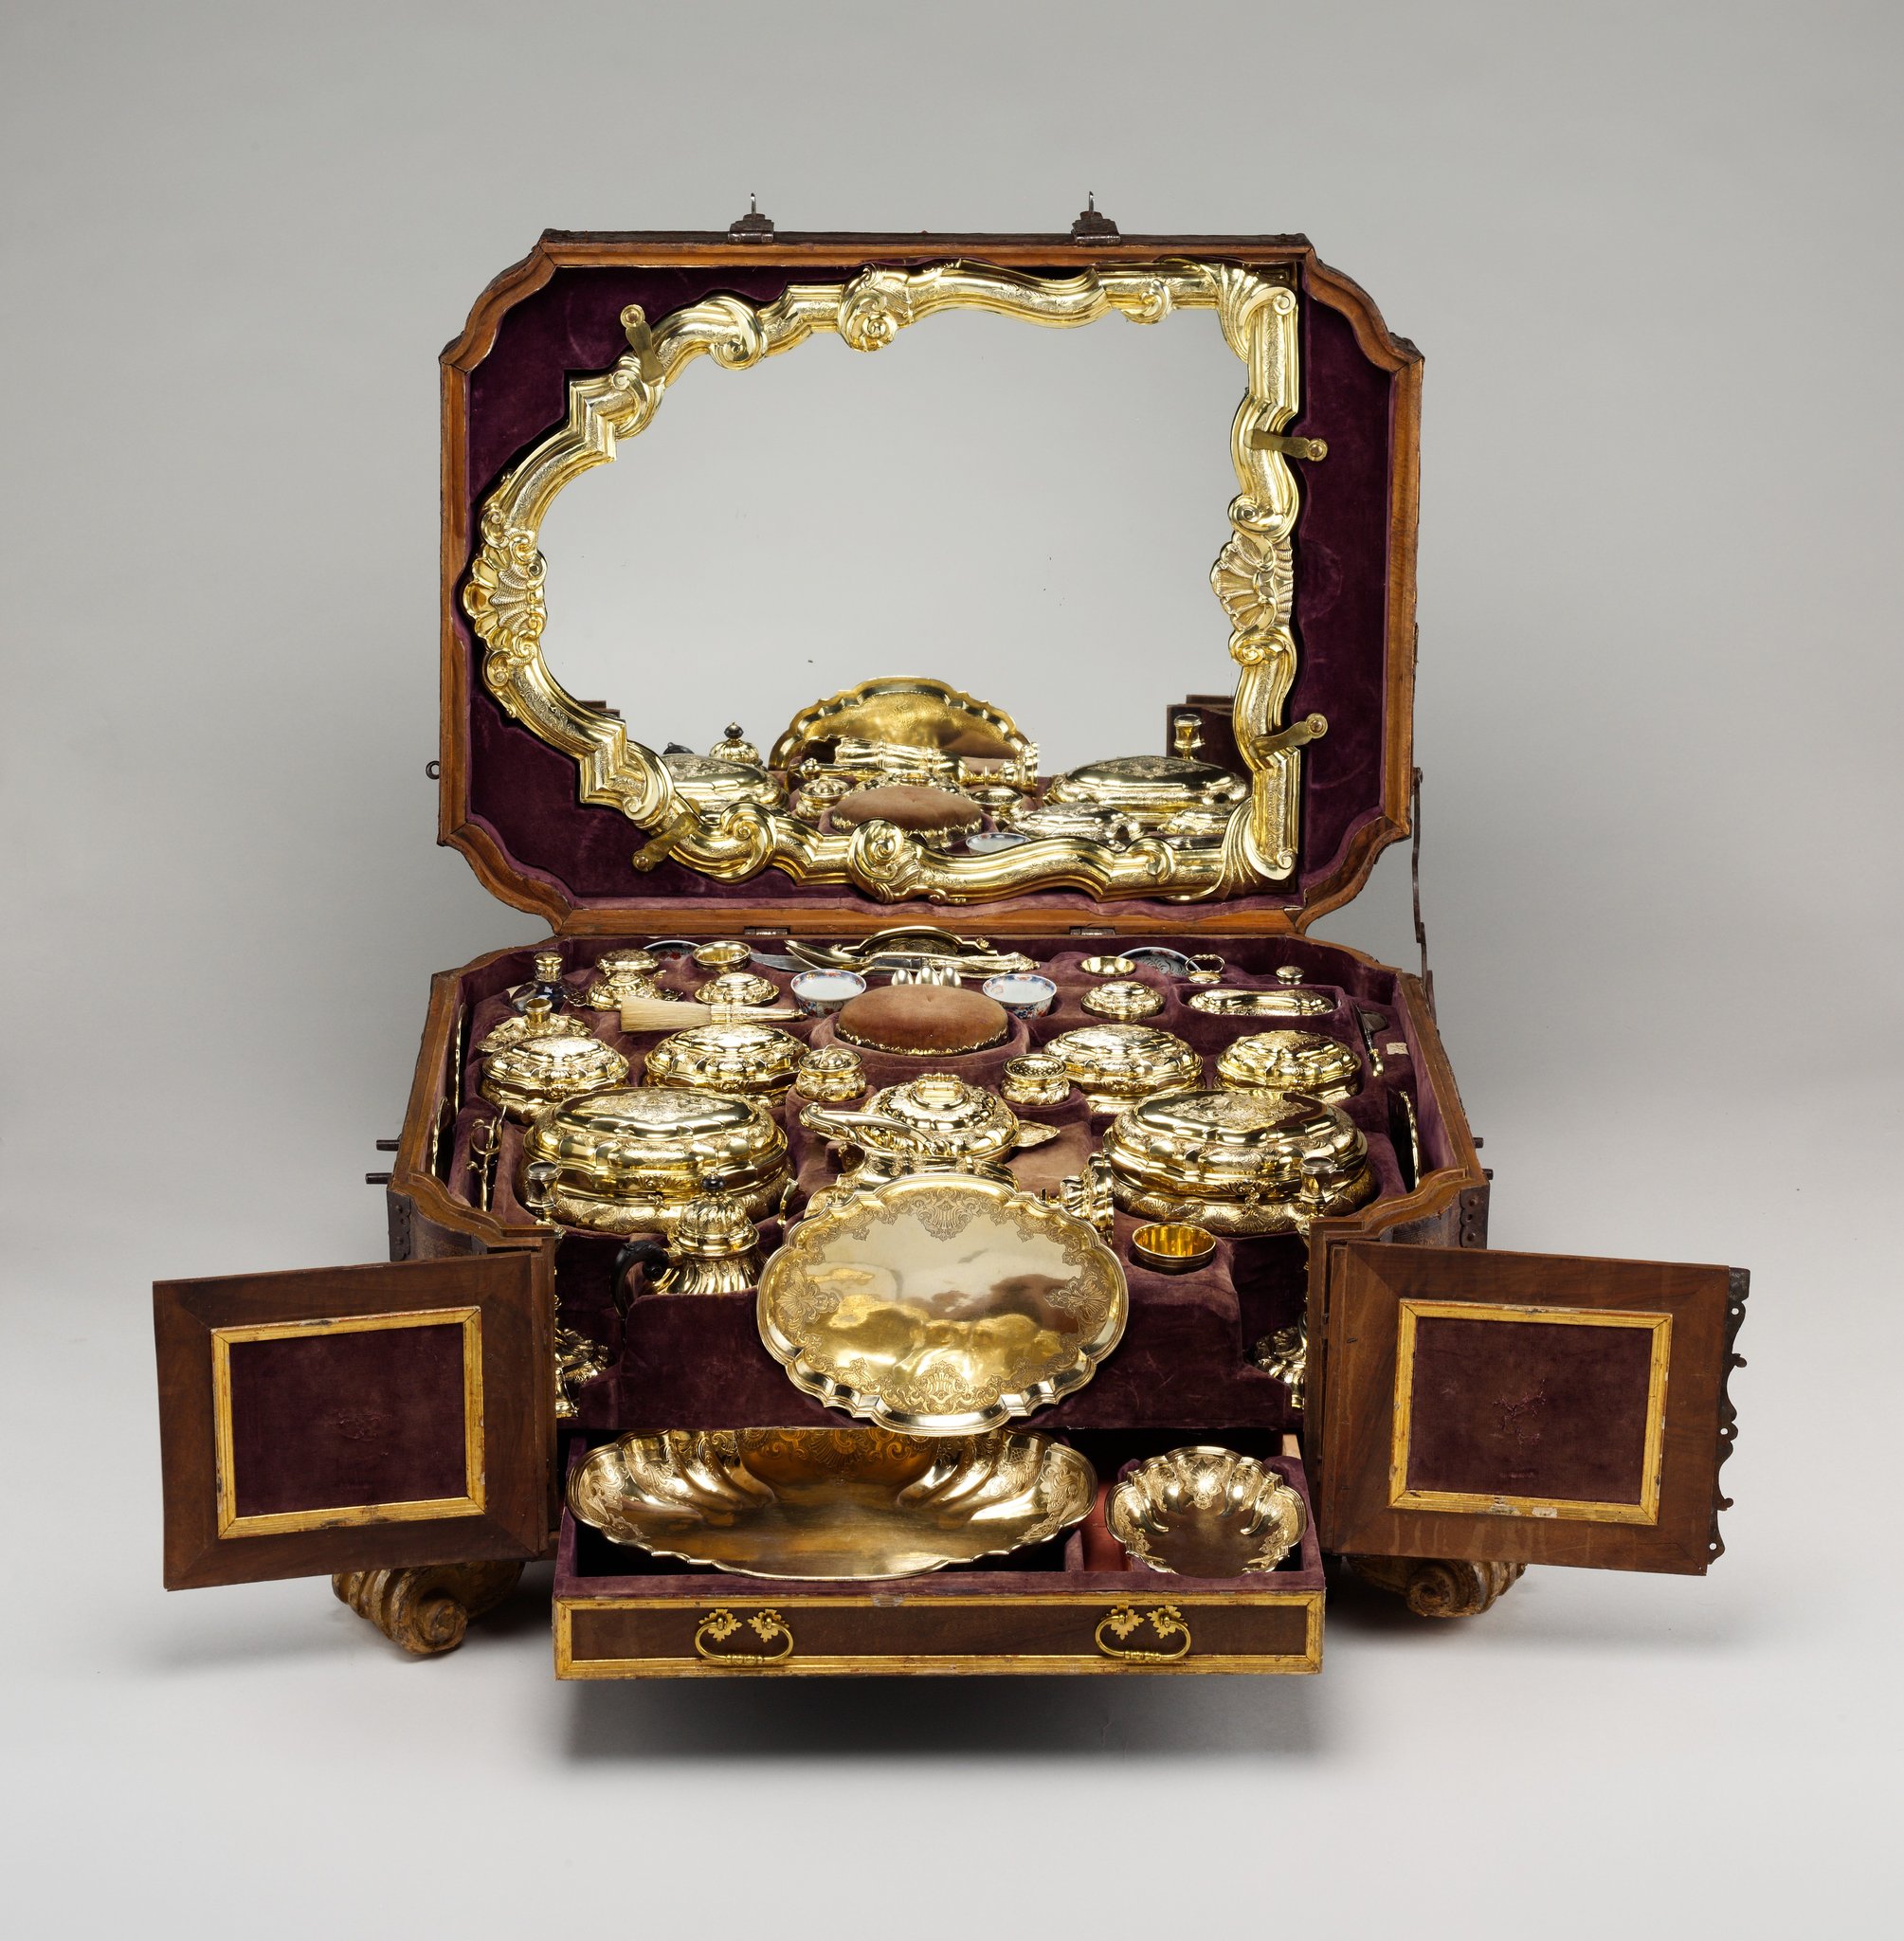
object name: toilet set case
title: Toilet set in original leather case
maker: fourteen identified german (augsburg) goldsmiths and other german artisans; japanese (imari) porcelain maker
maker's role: artist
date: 1743-1745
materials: gilt, silver gilt, glass, hard paste porcelain, iron, leather, paper, steel, wood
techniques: carving, cutting, tooling